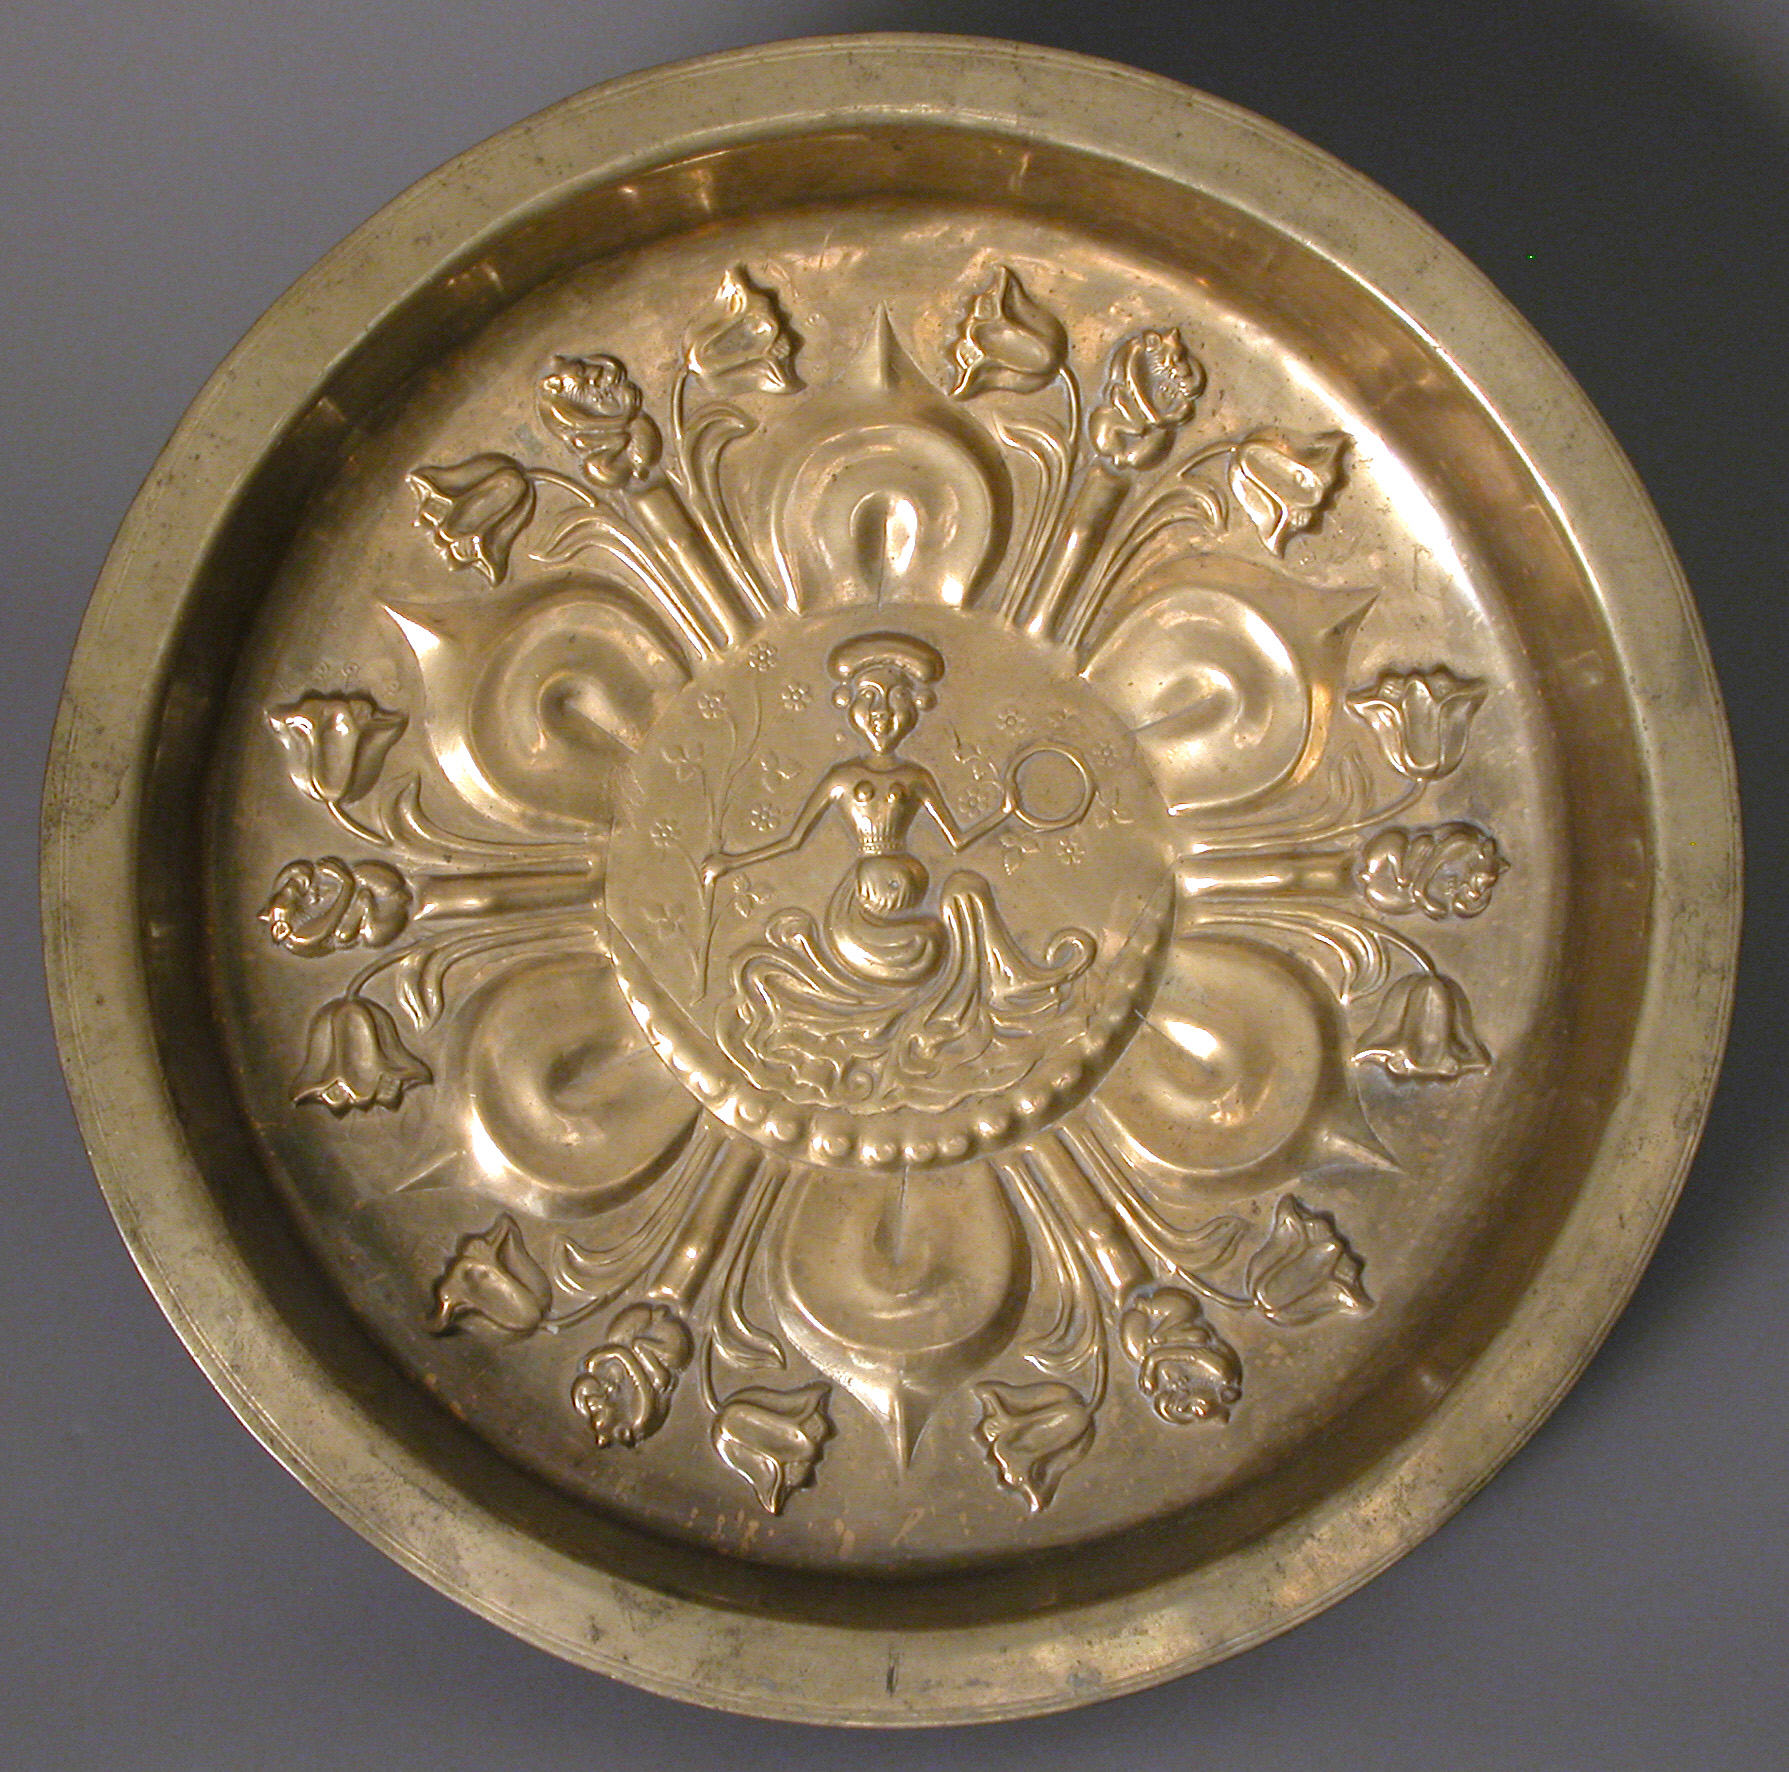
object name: plate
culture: german or south netherlandish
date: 1480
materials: brass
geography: germany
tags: women,flowers